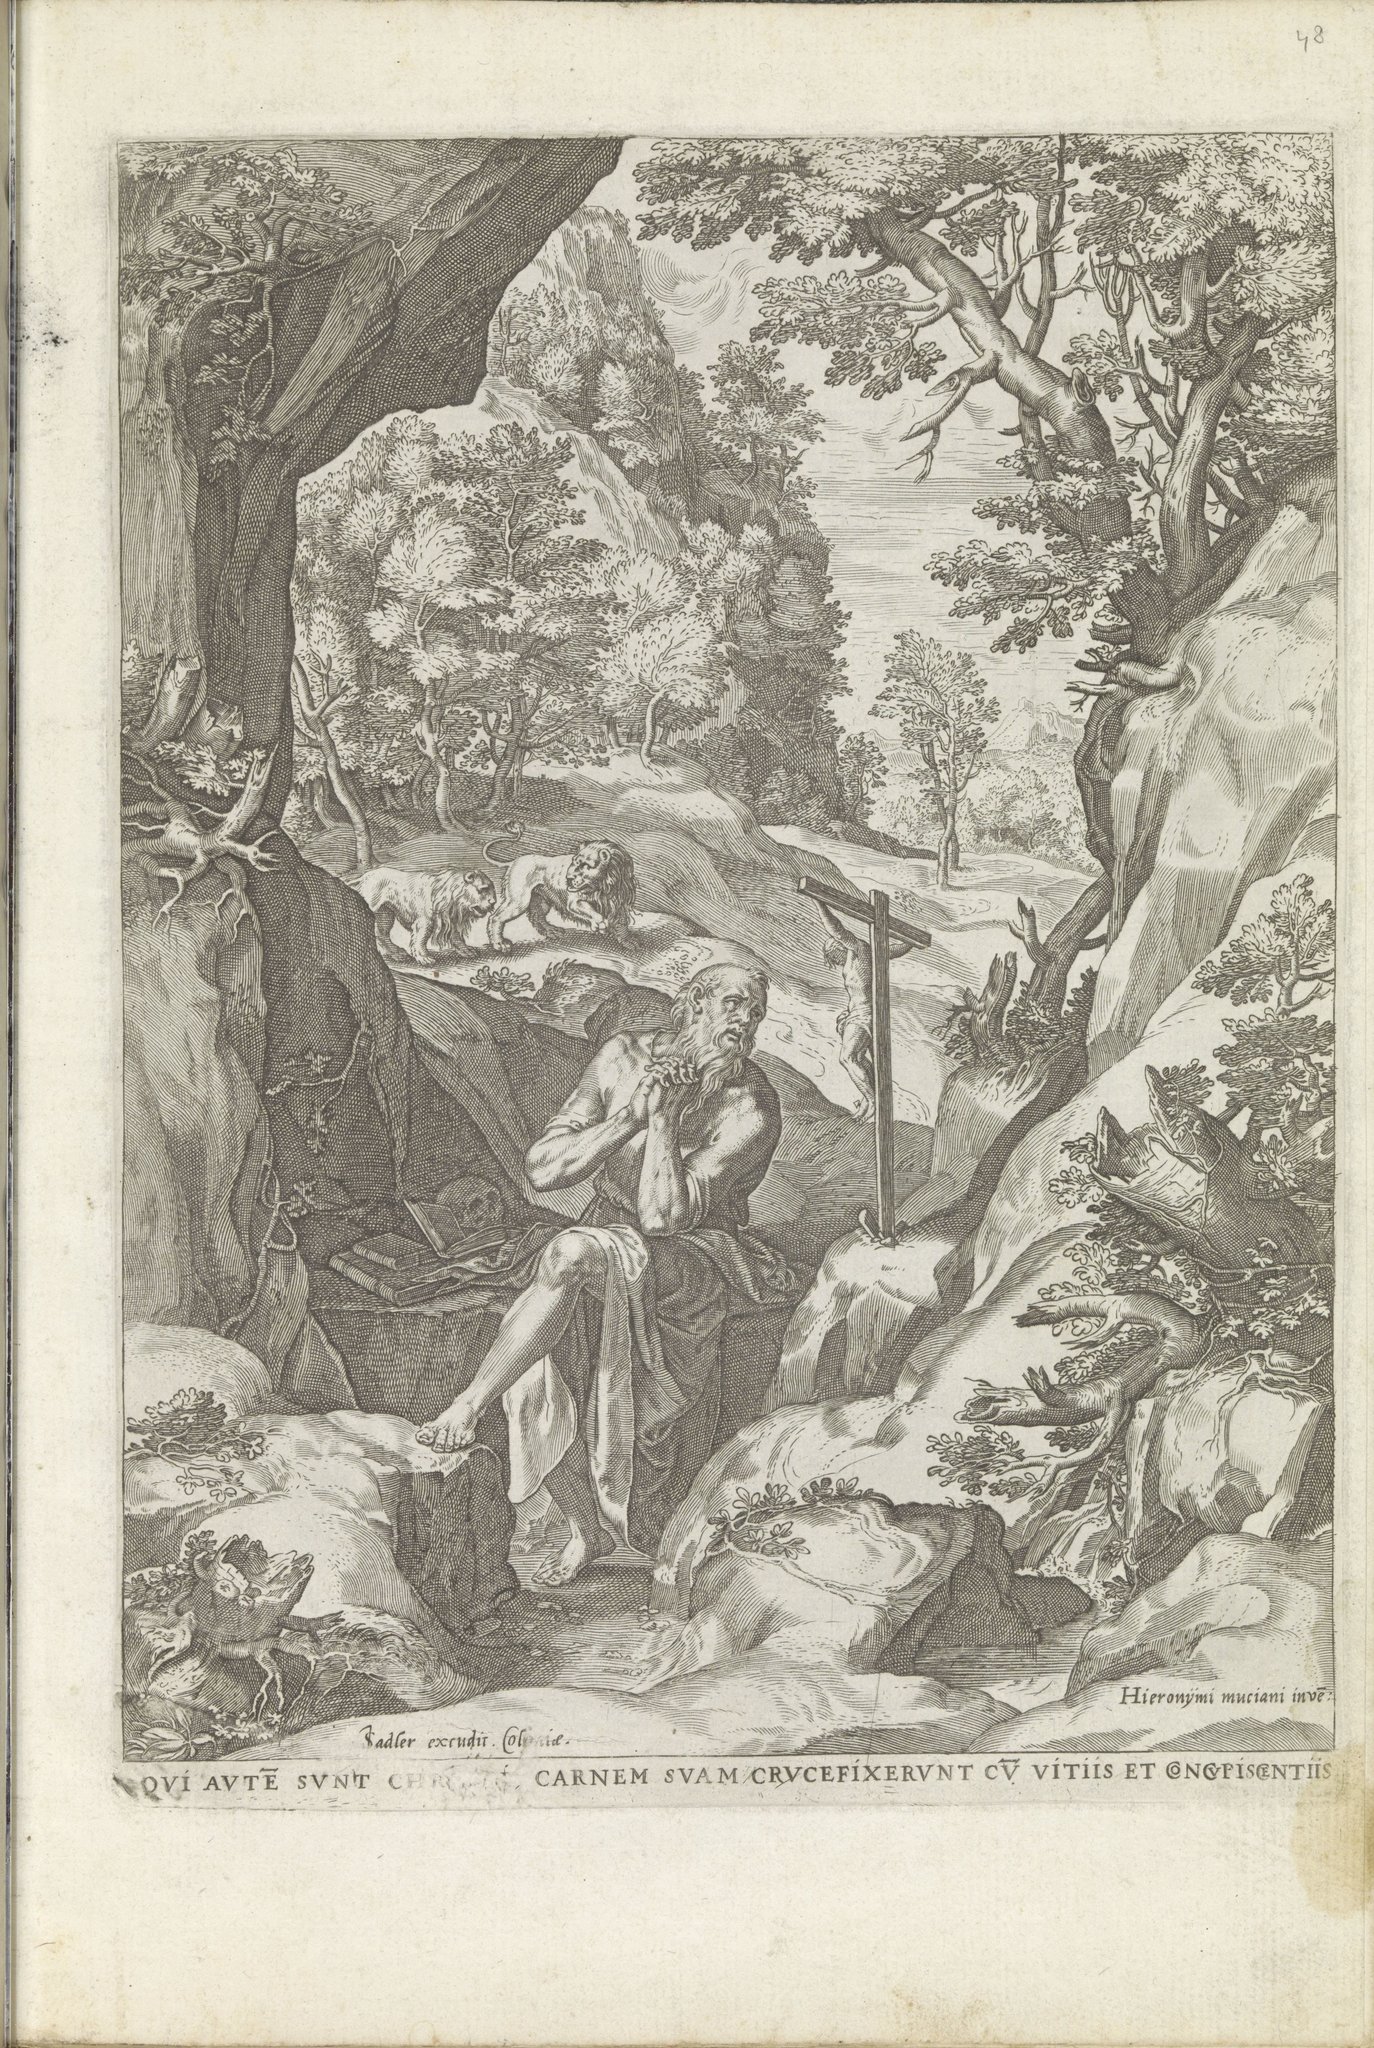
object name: print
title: Landschap met de H. Hieronymus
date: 1579-1586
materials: paper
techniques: engraving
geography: cologne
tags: st. jerome as penitent in the desert, half naked, kneeling before a crucifix and holding a stone in his hand to beat his breast; a skull (and other 'vanitas' symbols), sometimes a scorpion and a snake beside him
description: Hieronymus, biddend voor een crucifix in een landschap, naast hem boeken en een schedel. Op de achtergrond twee leeuwen. Deze prent maakt deel uit van een album.